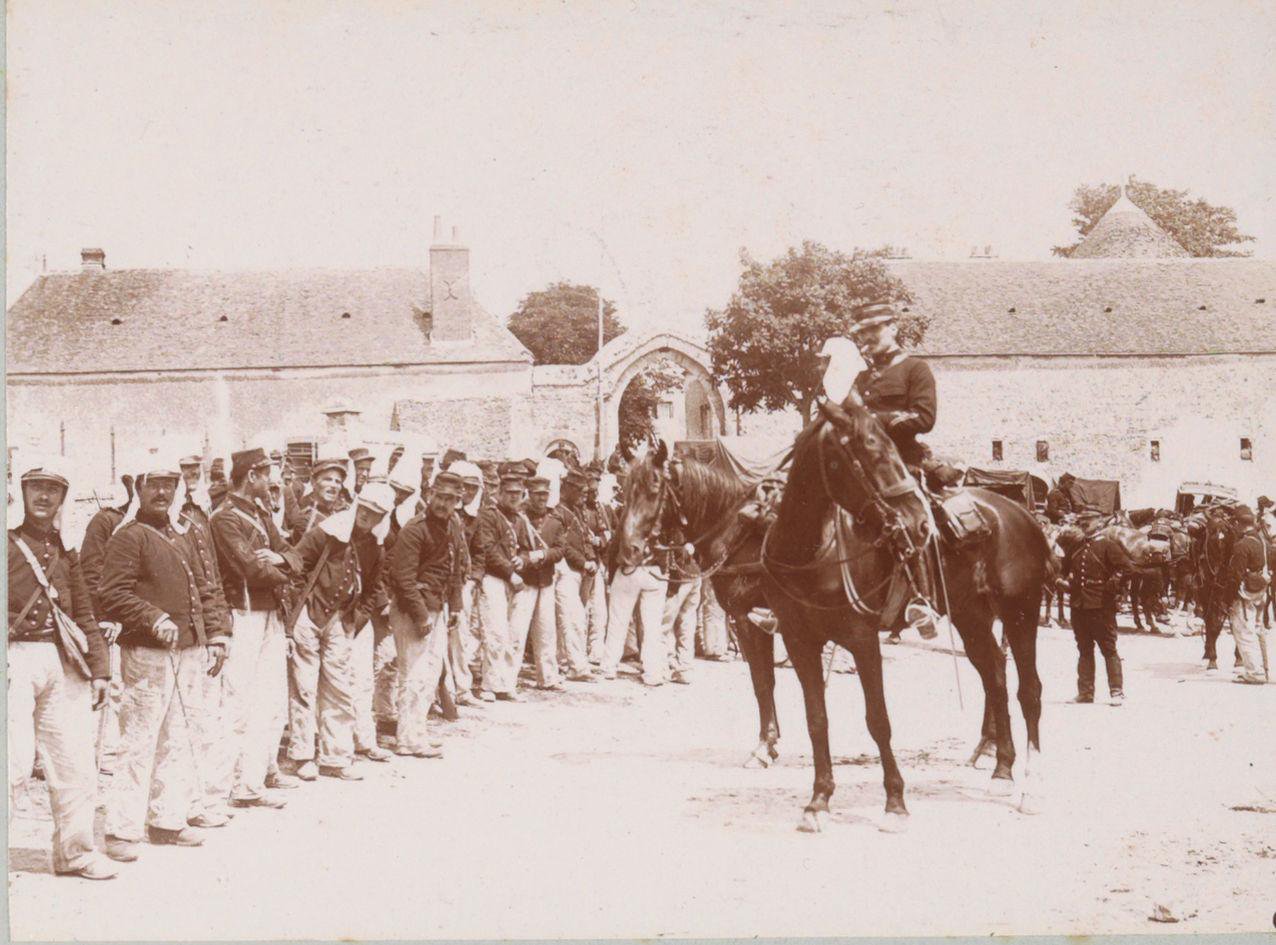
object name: photograph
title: Militairen te paard en te voet in Puiseaux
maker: delizy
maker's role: manufacturer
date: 1896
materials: paper, photographic support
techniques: gelatin silver print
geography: puiseaux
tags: land forces (+ cavalry, horsemen)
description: Onderdeel van Fotoalbum van een Franse amateurfotograaf met opnames van uitstapjes in Frankrijk, Spanje, België, Luxemburg en Nederland, de eerste automobielen en autoraces.